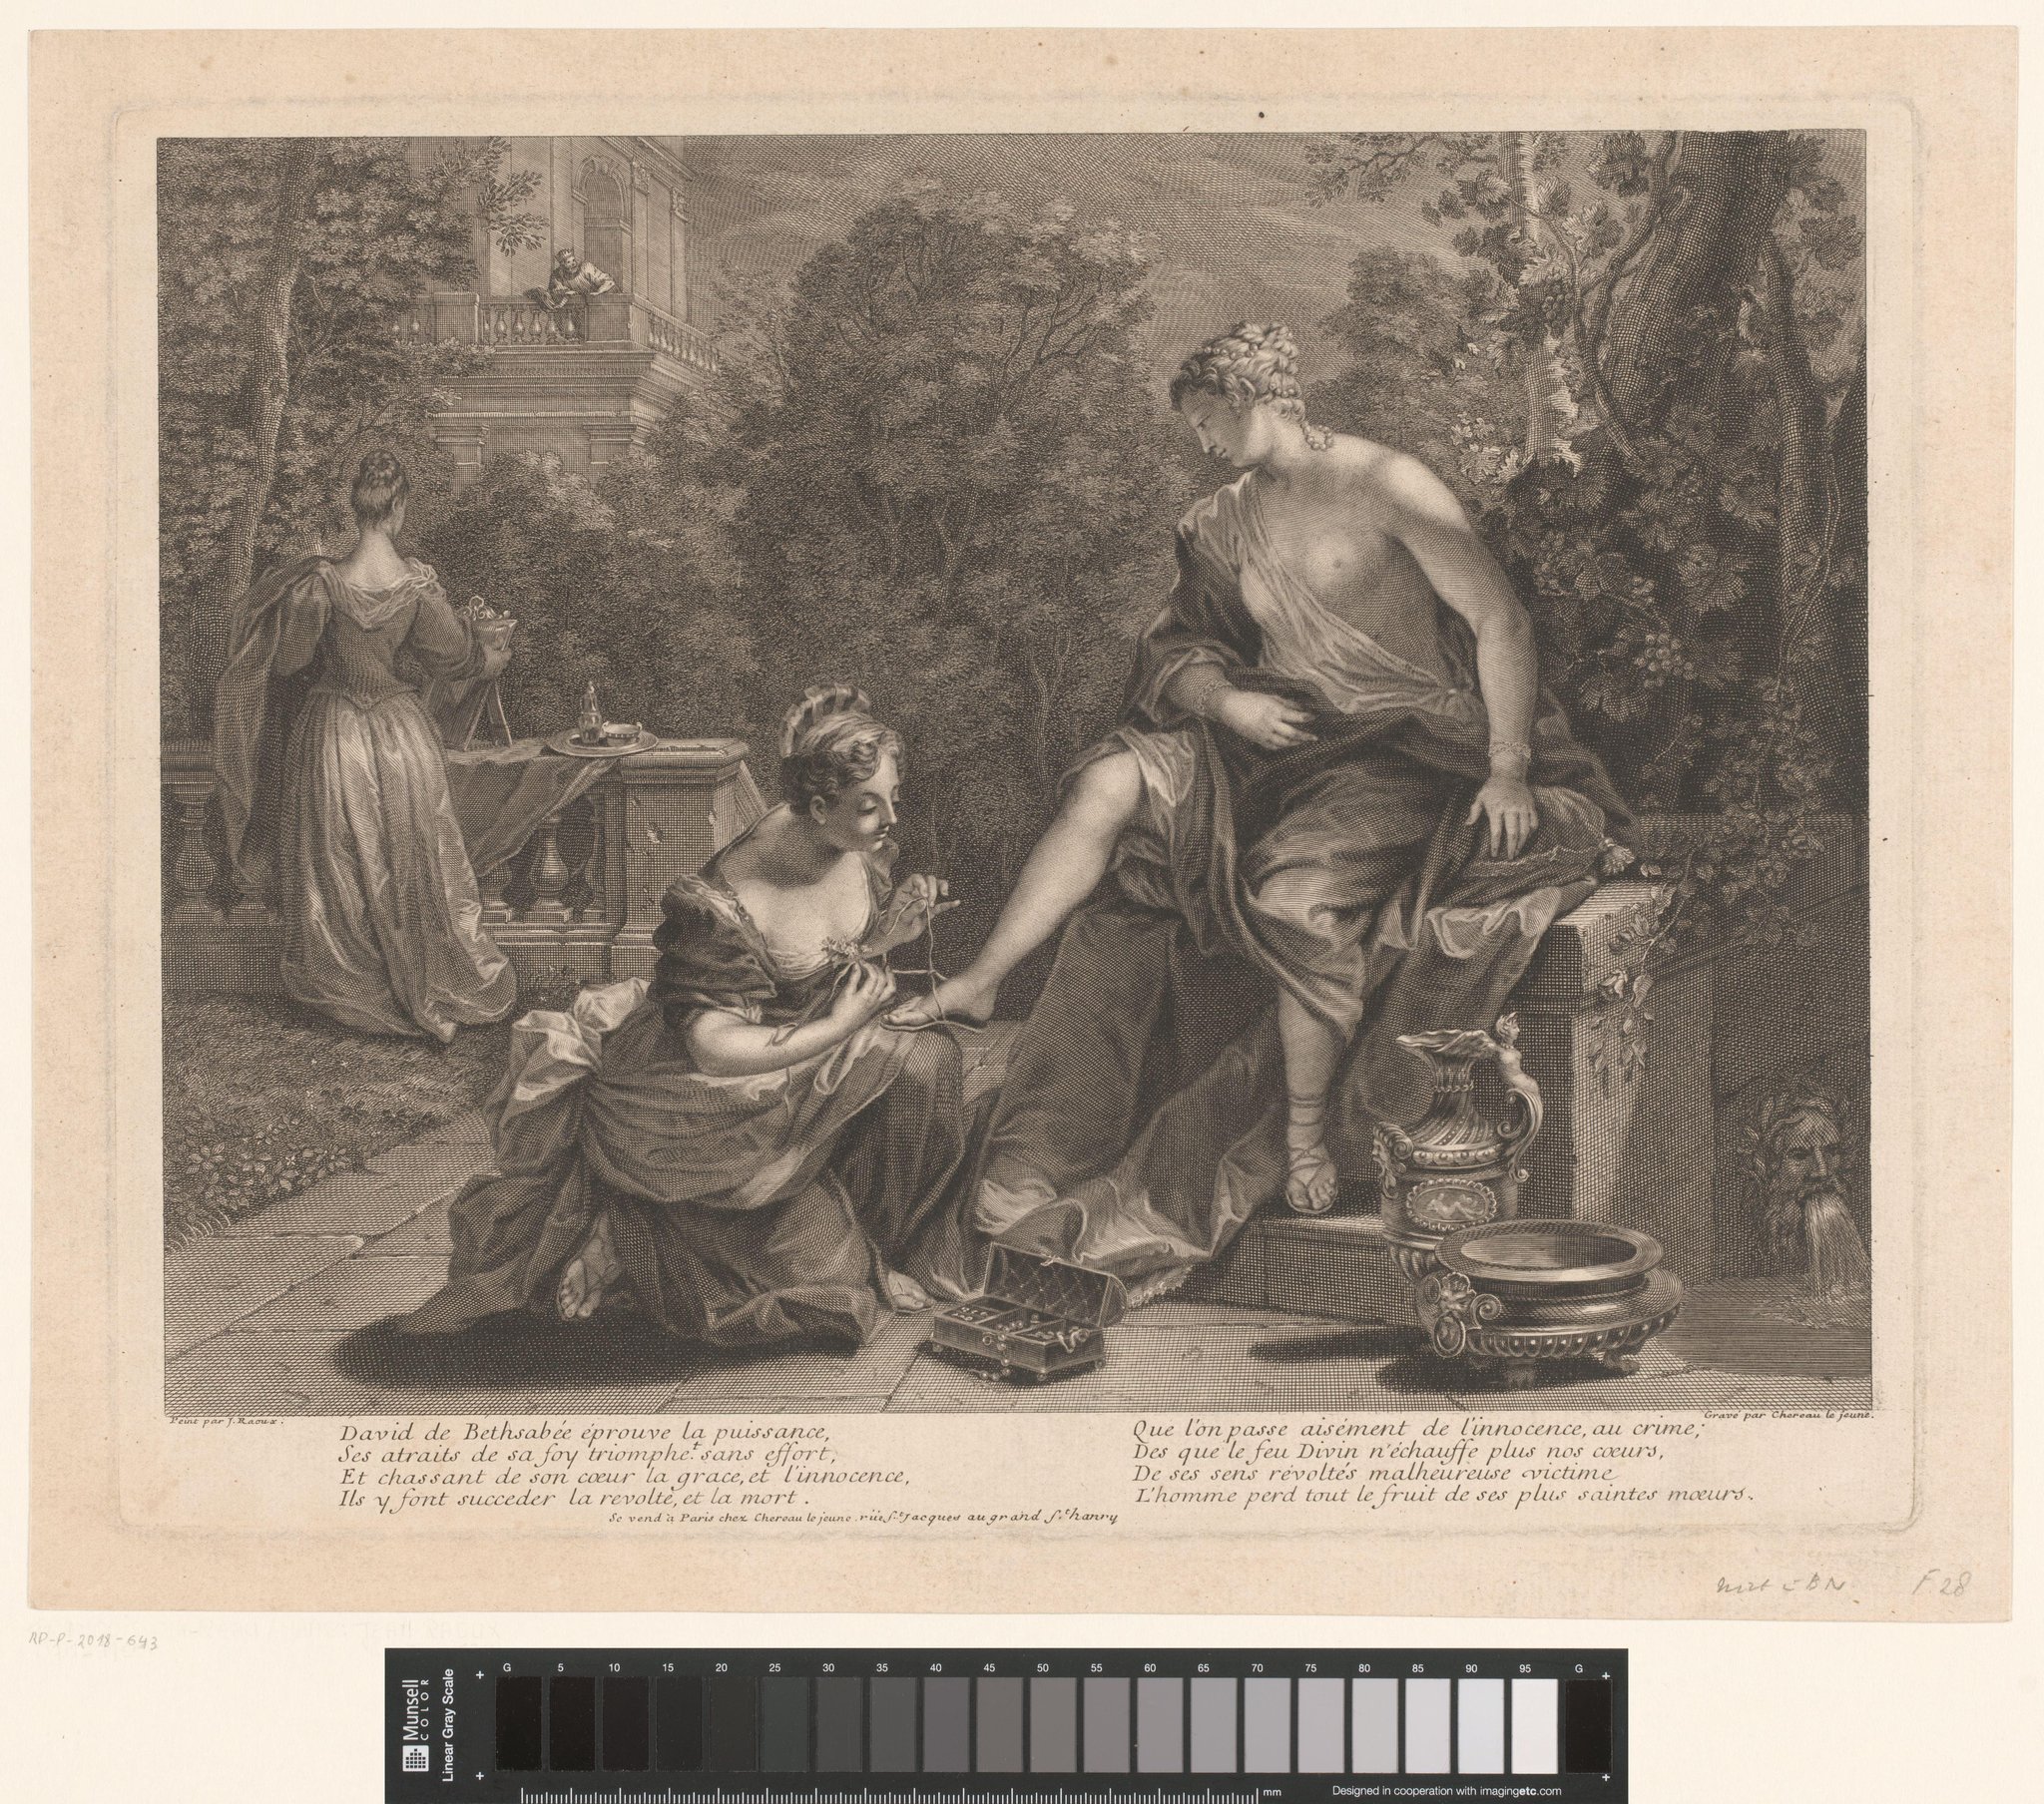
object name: print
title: Batseba door David begluurd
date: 1698-1776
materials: paper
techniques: engraving, etching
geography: france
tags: putting on (tying) or taking off (untying) sandals or shoes, jewel-box, bathsheba attended by servant(s)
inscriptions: watermark, collector's mark: Lugt 2228